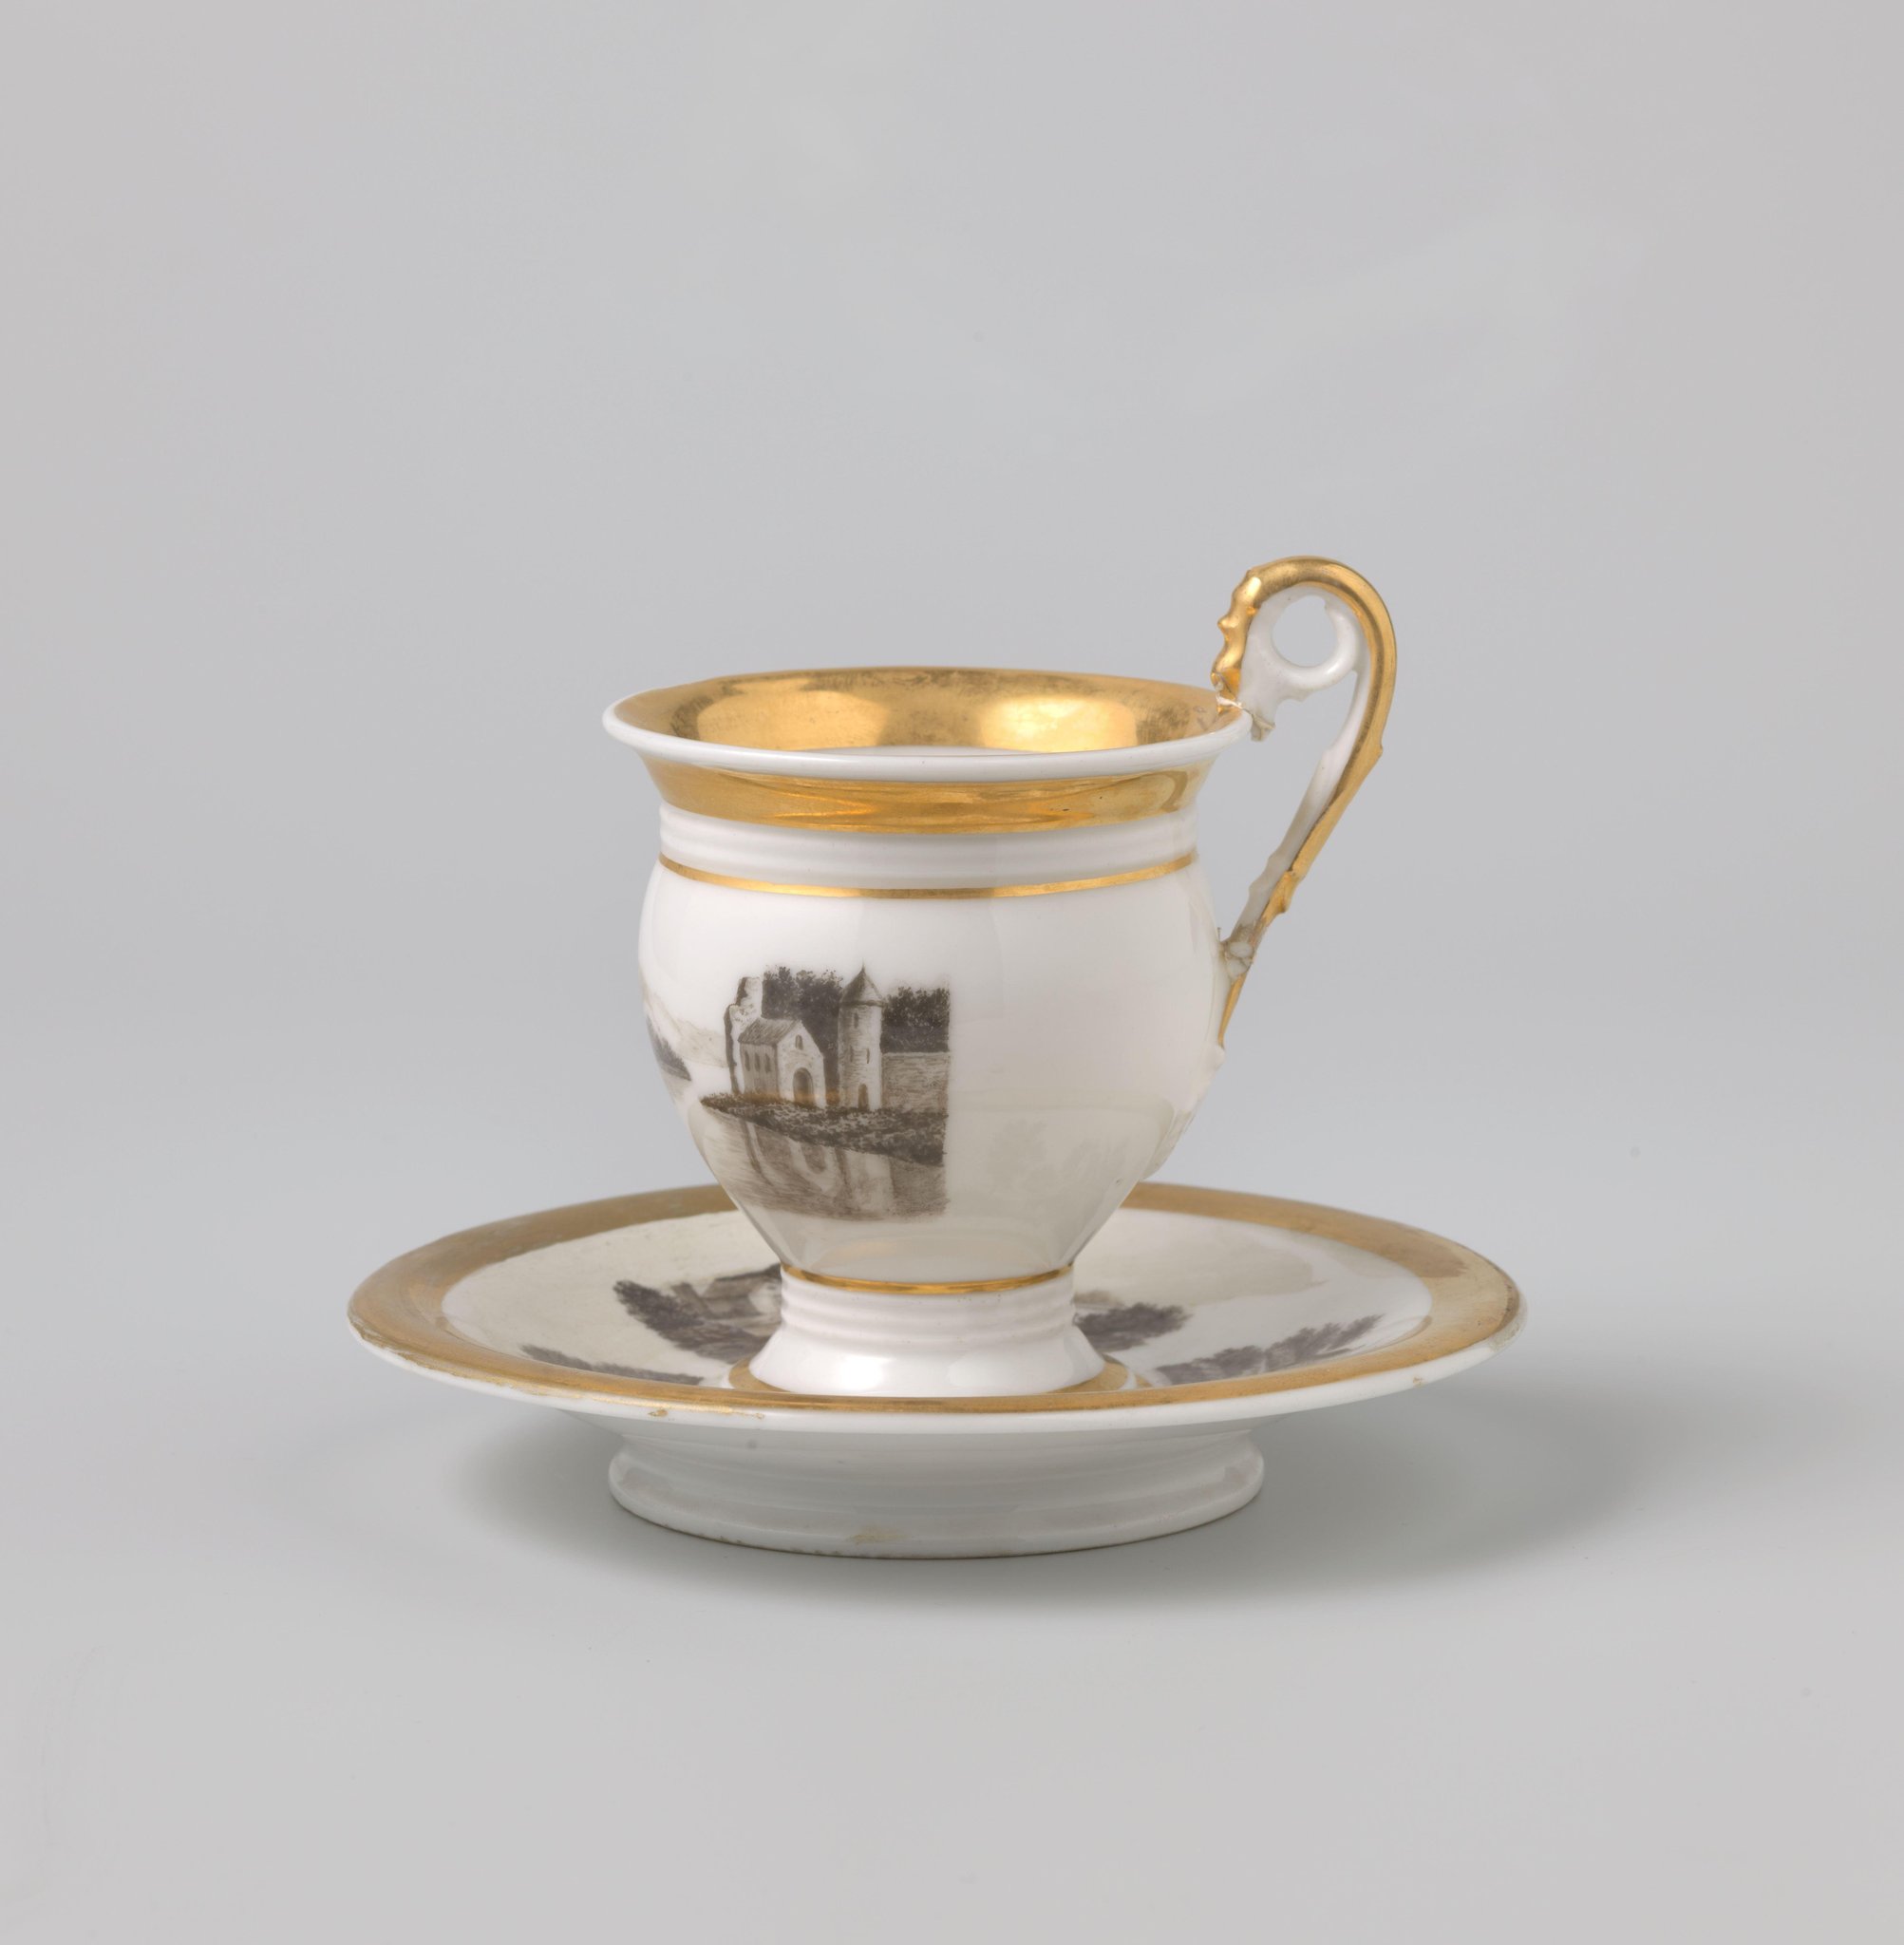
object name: cup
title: Cup with a water landscape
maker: Anonymous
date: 1850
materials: glaze, gold, paint, porcelain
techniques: firing, forming, gilding, turning, vitrification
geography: europe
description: Kop met bijbehorende schotel (B) van porselein. Kop op hoge voet, met hoogopgaand oor. Langs de voet- en mondrand brede gouden biezen. Binnenkant mondrand van de kop ook verguld, evenals het oor. De kop heeft tussen voet en lichaam en onder de mondrand ribbels. Beschilderd in encre-de-Chine met een rivierlandschap met gebouwen aan de oevers. Opmerking: oor nieuw aangezet.